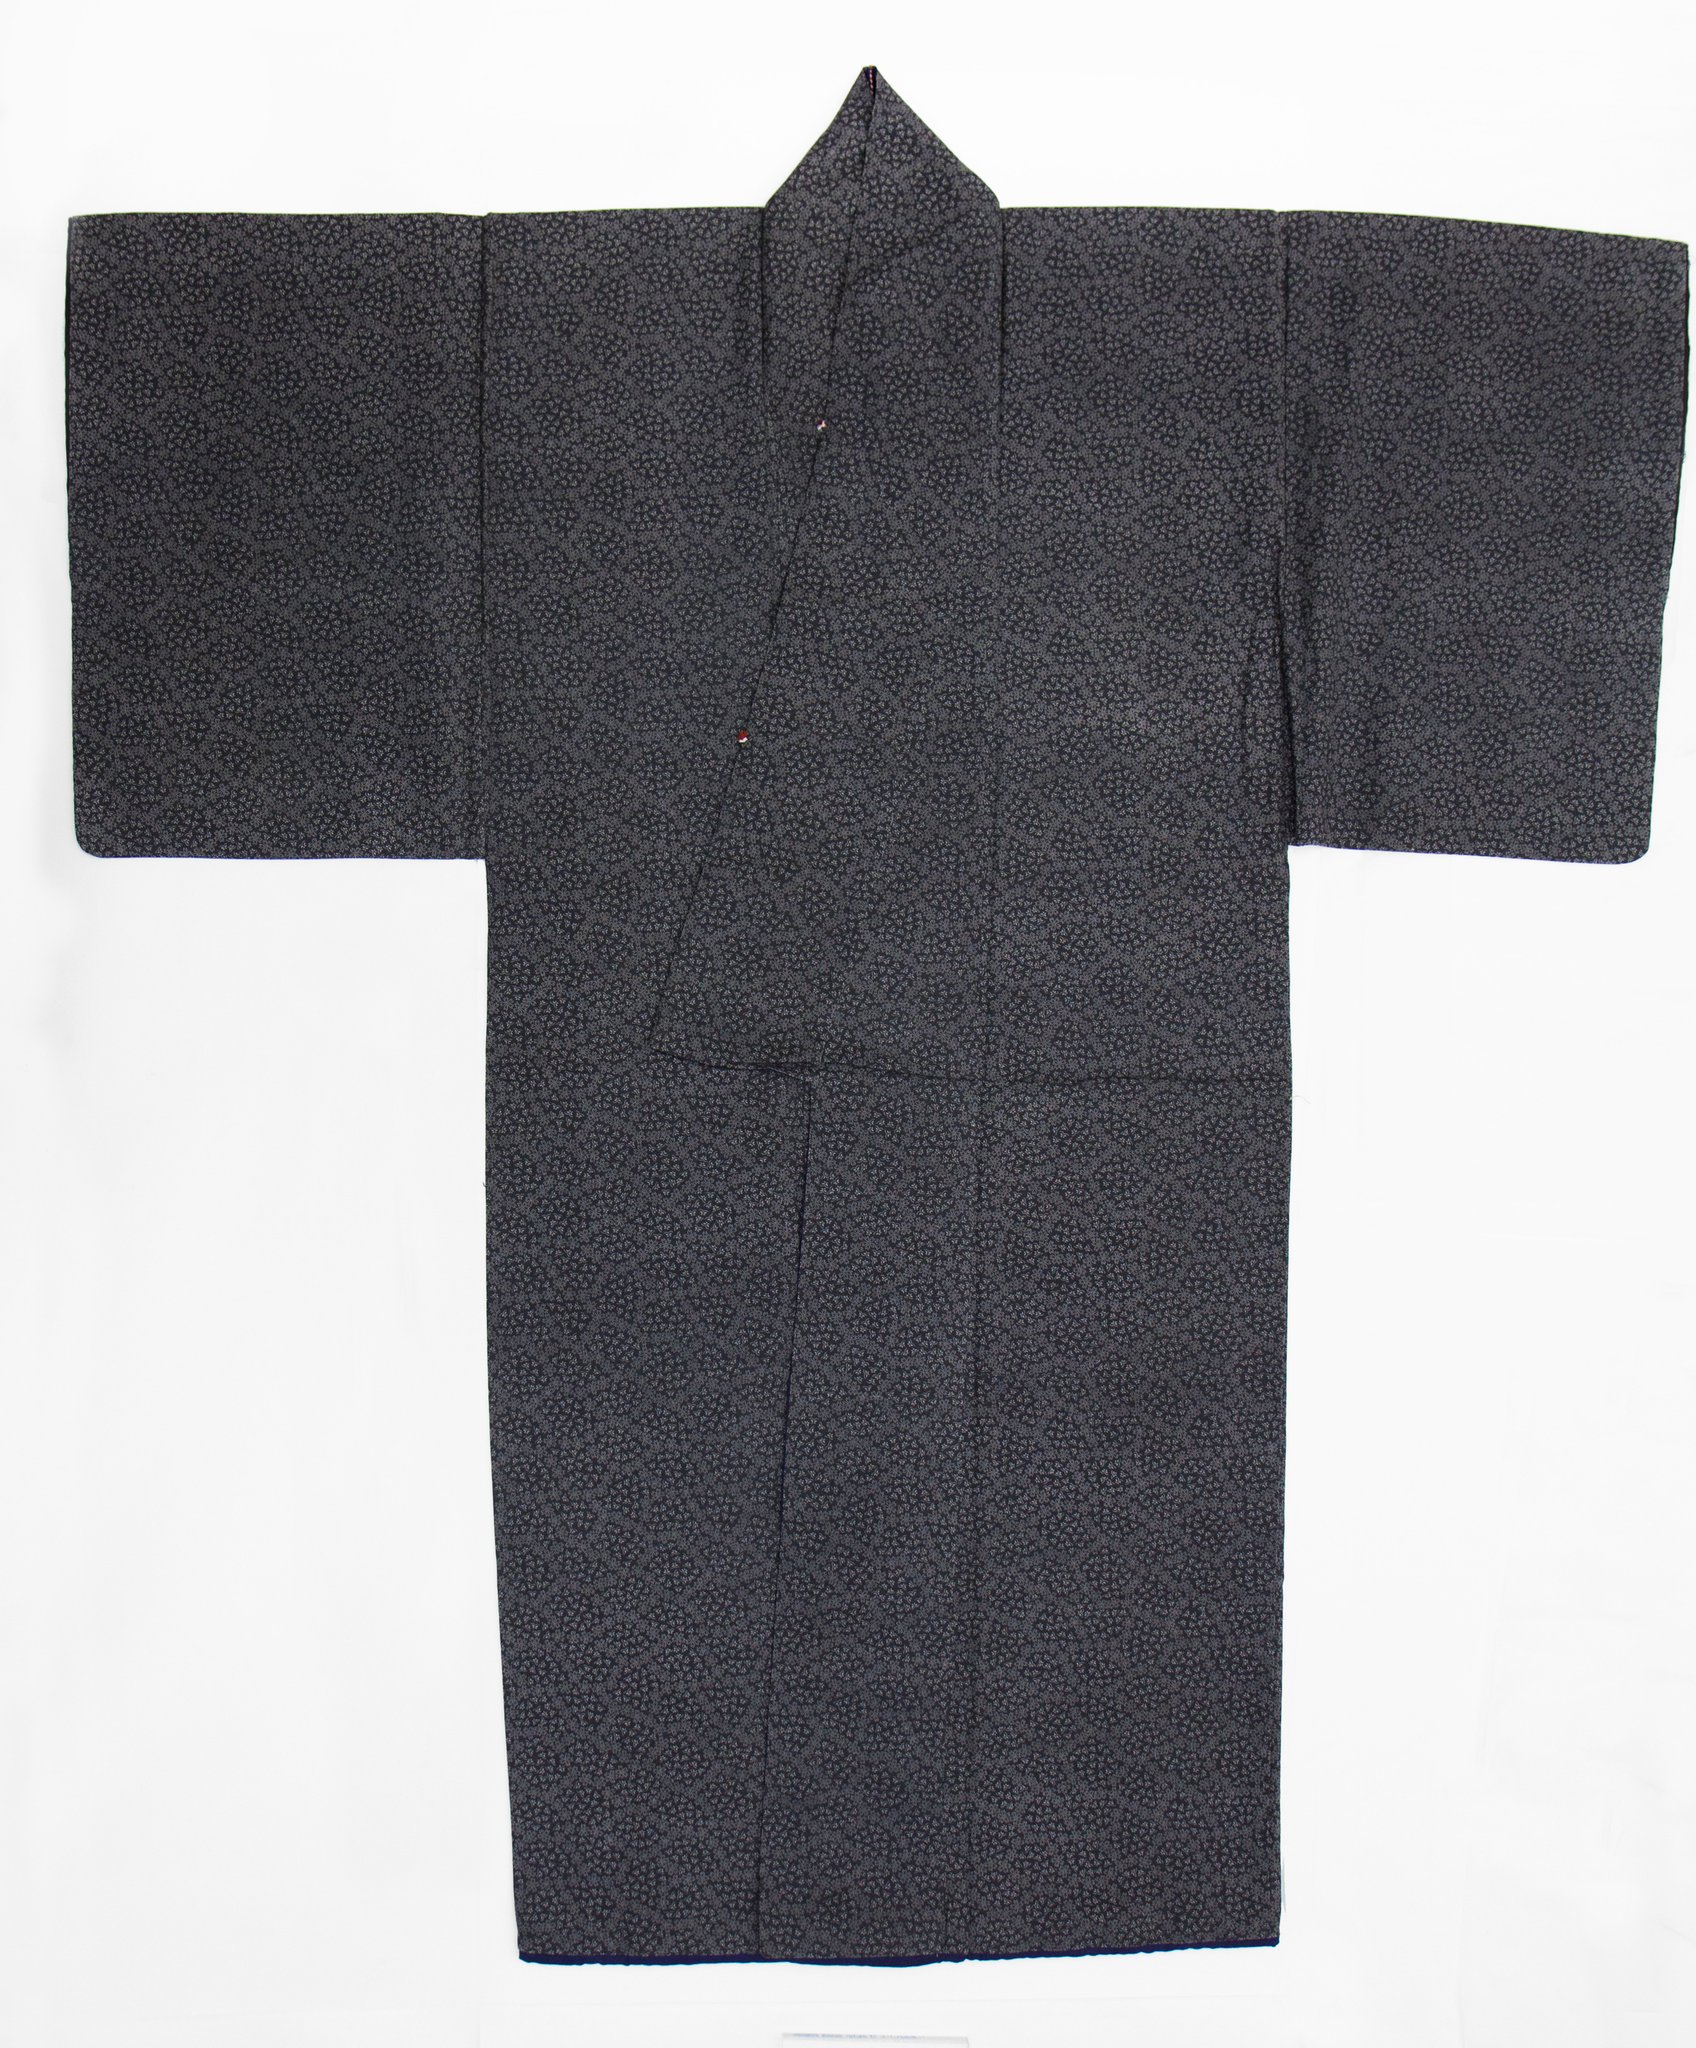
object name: kosode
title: Robe (Kosode) with Cherry Blossoms and Butterflies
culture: japanese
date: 1767-1833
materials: silk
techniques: weave